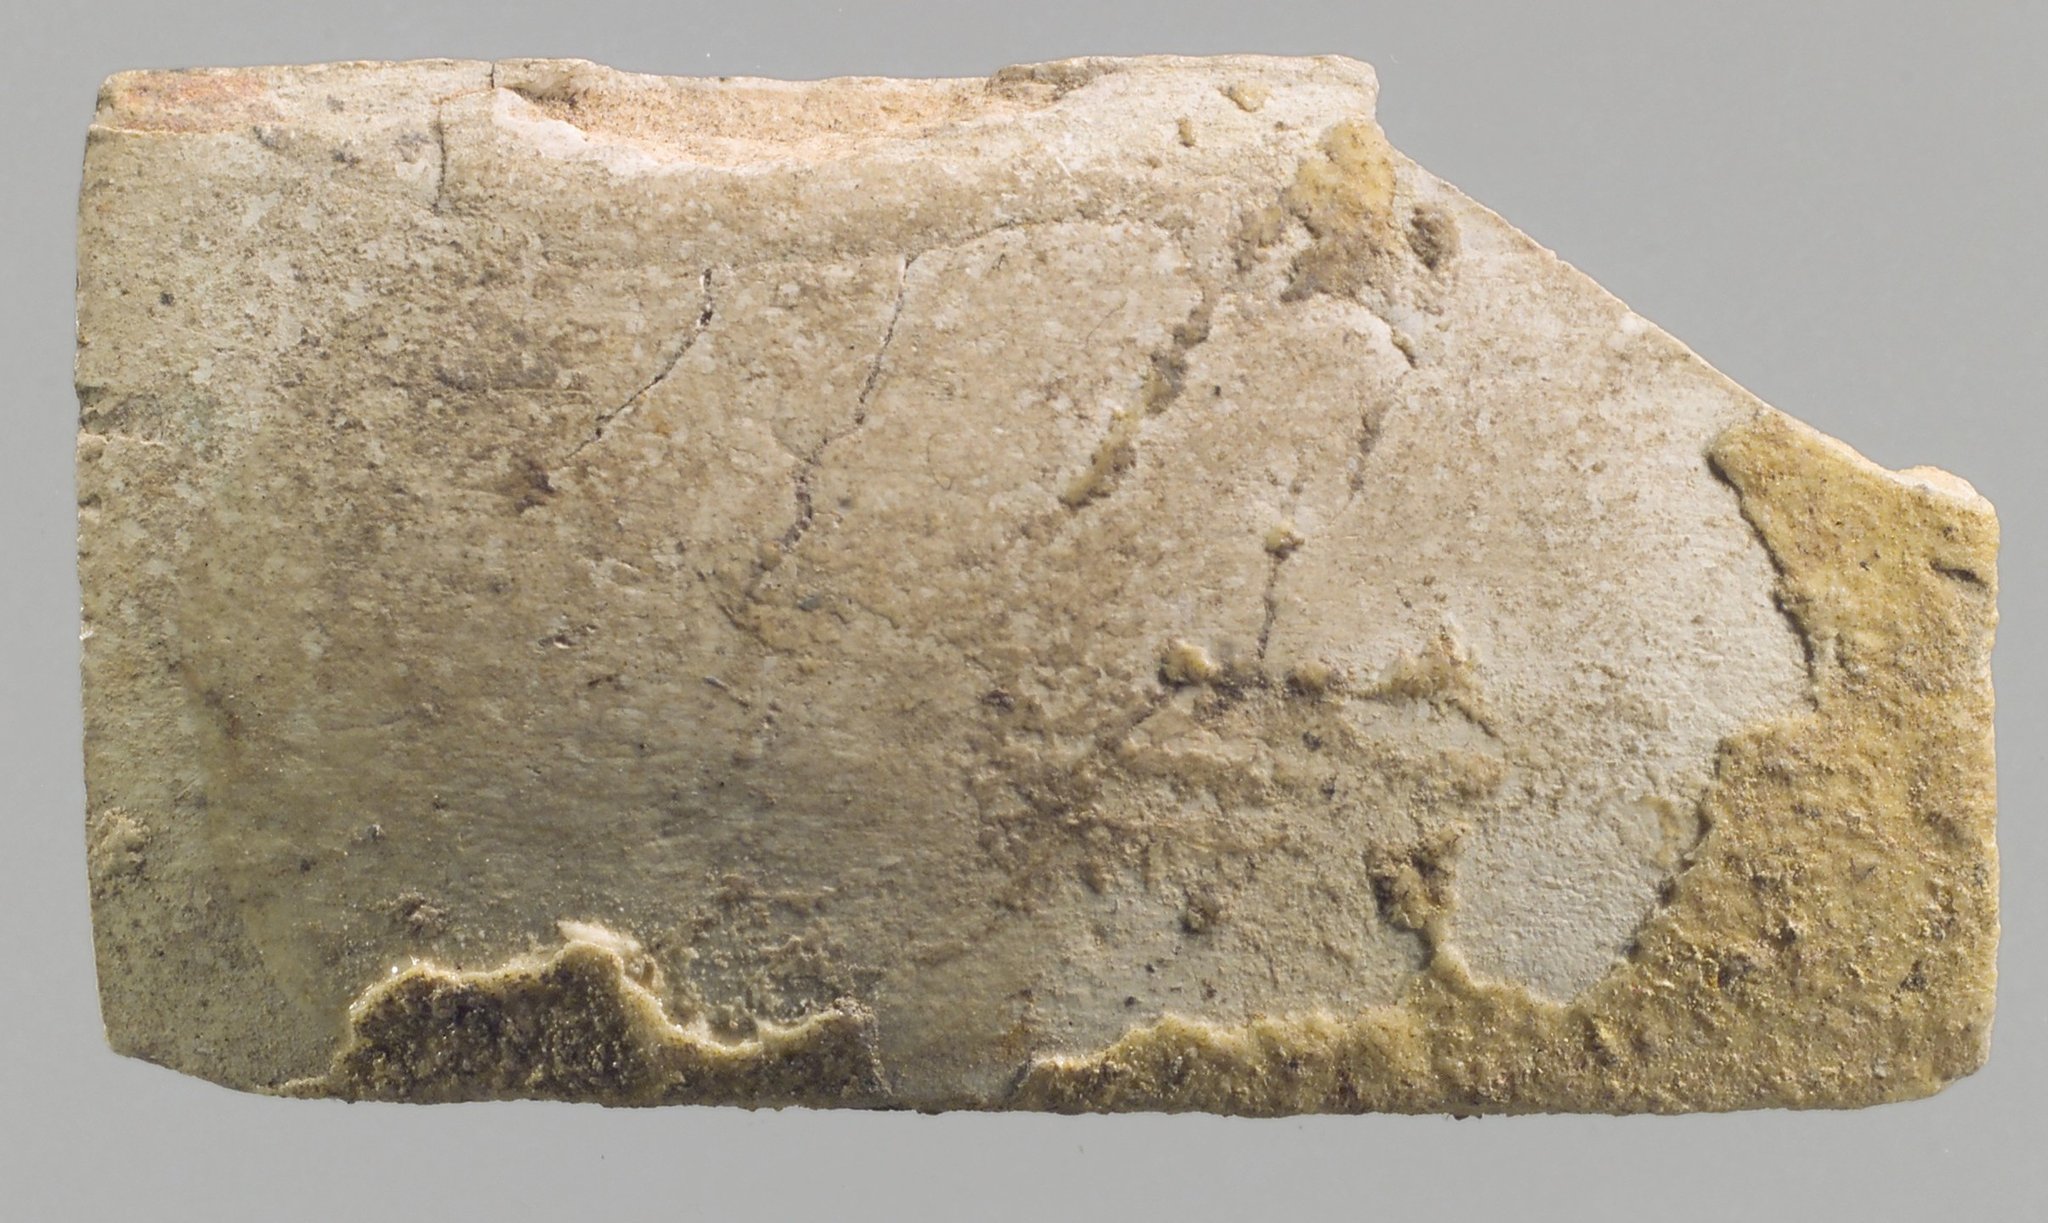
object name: plaque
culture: assyrian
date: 1800-1701 BCE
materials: ivory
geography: anatolia